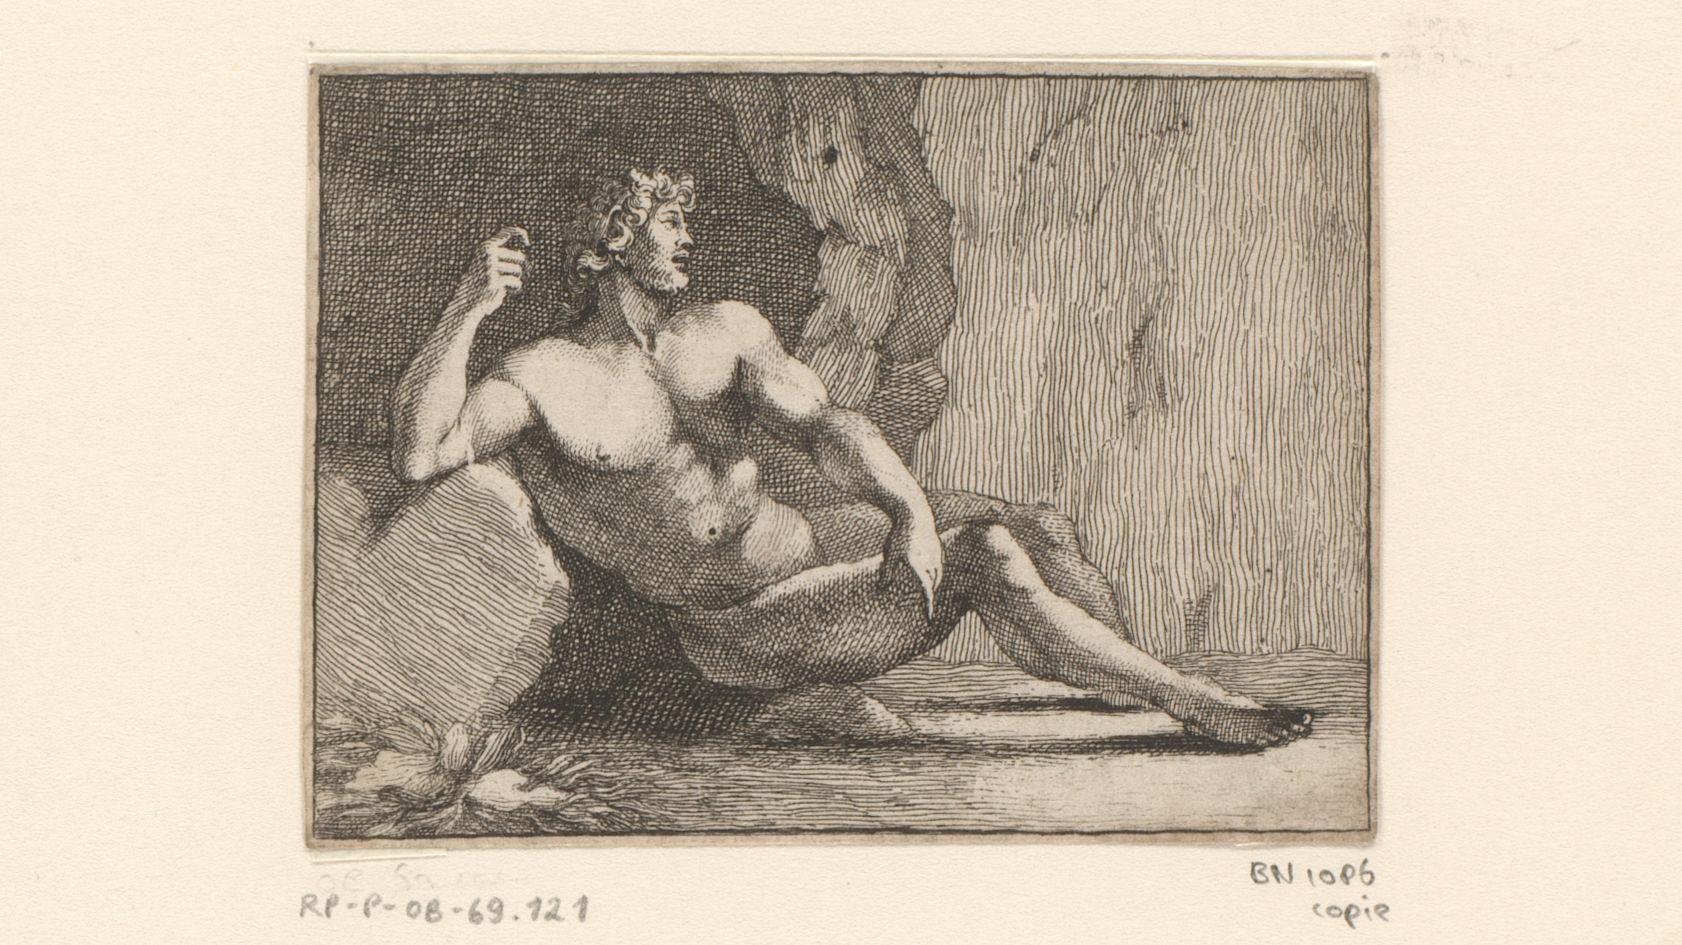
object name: print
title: Naakte jonge man, mogelijk Endymion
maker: Anonymous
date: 1647-1714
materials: paper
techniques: engraving, etching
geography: france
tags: diana (luna) visiting the sleeping endymion, youth, adolescent, cave, grotto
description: Deze prent is een anonieme kopie naar de originele prent van Sébastien Leclerc.